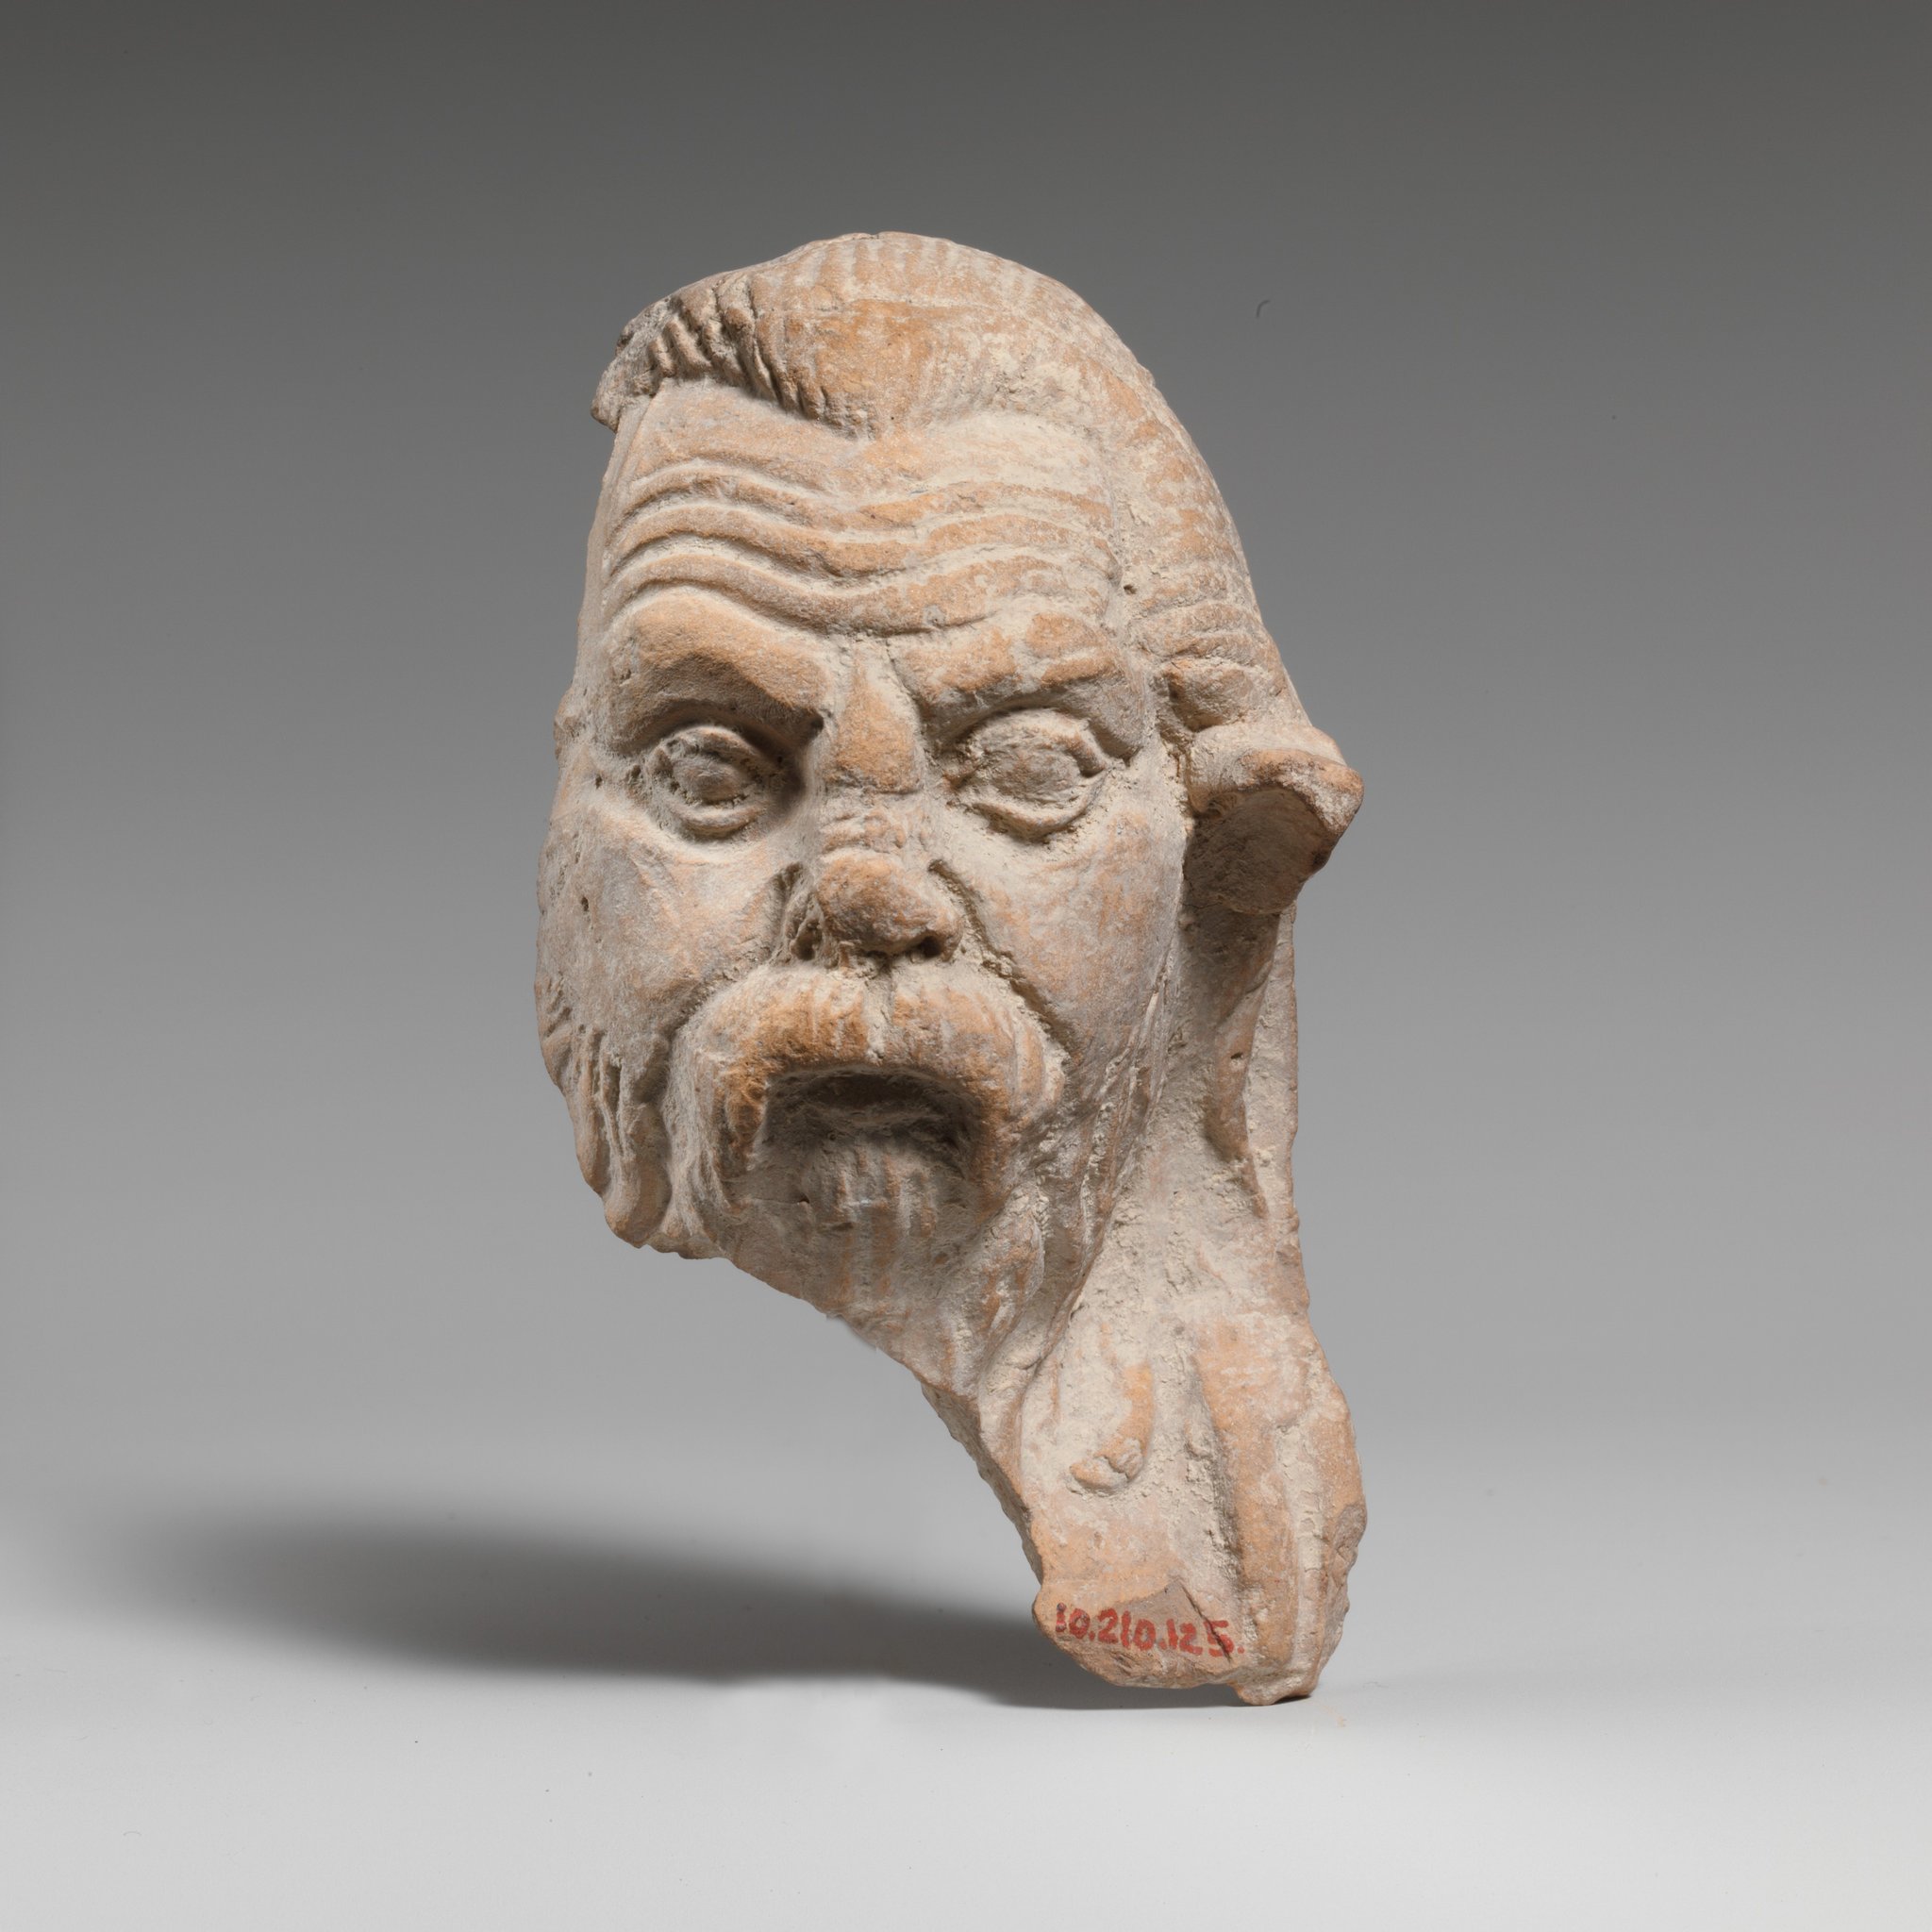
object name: head of a man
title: Fragment of a terracotta head of a satyr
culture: greek, south italian, tarentine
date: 400-301 BCE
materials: terracotta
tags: heads,satyrs